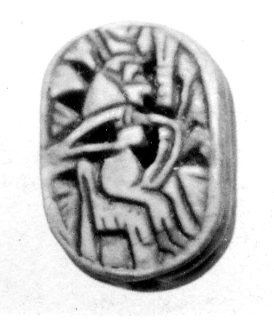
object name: oval plaque, isi, papyrus, kheper beetle, nub, monkey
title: Oval plaque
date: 733-664 BCE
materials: stone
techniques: glazing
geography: egypt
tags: human figures